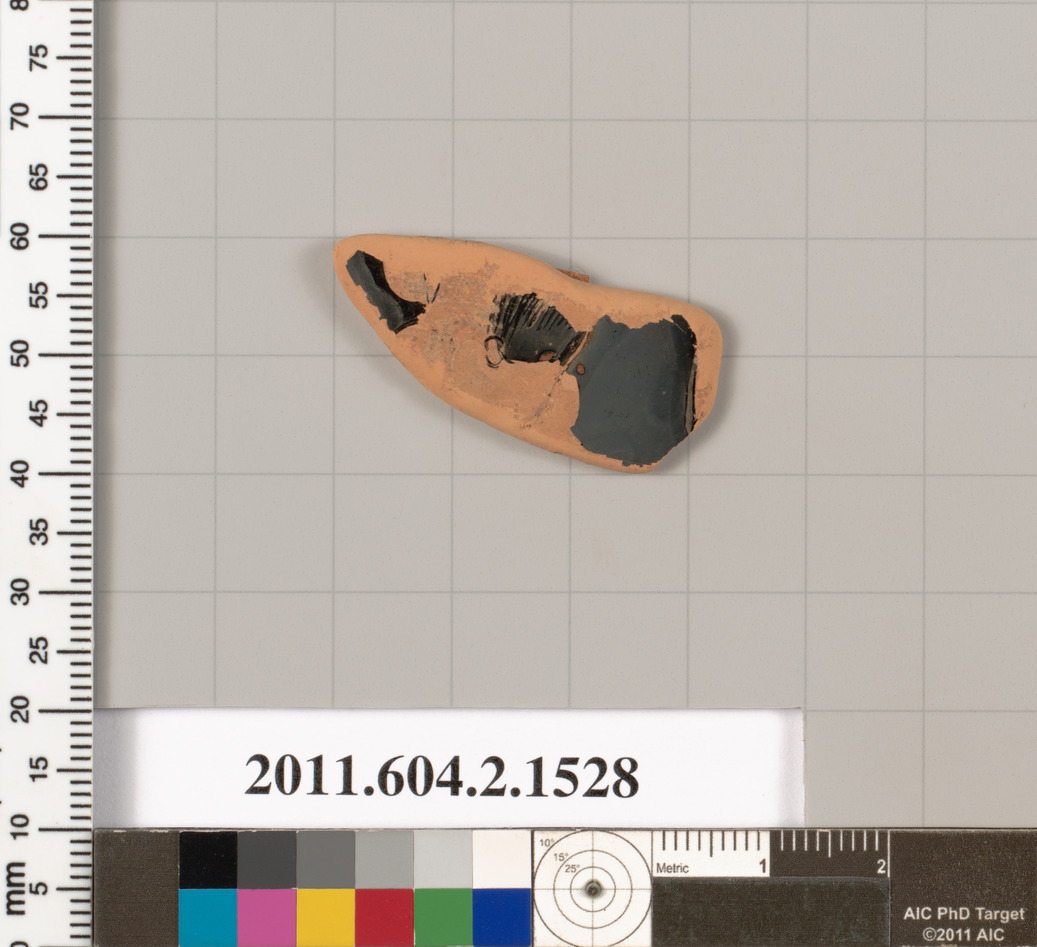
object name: skyphos fragment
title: Terracotta fragment of a skyphos (deep drinking cup)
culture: greek, attic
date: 500-451 BCE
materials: terracotta